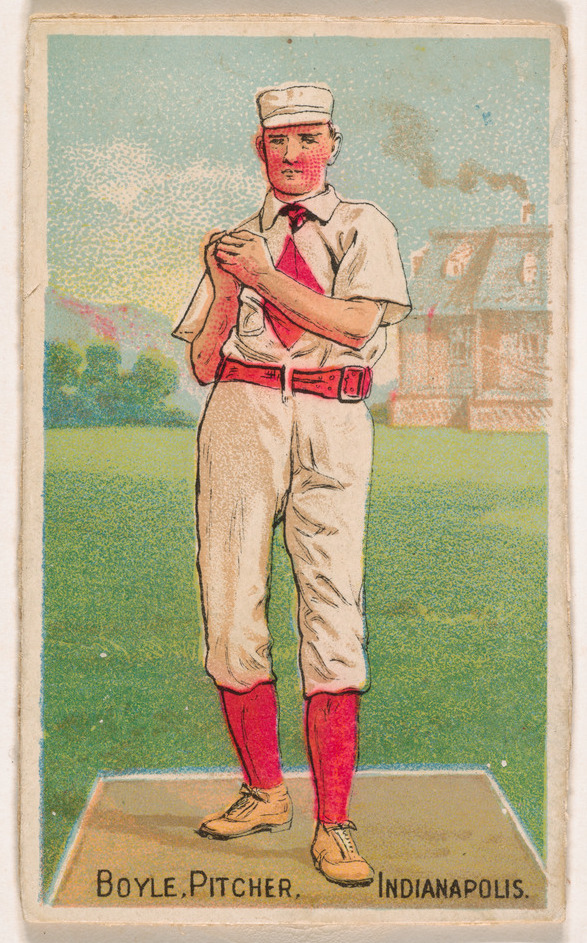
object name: baseball card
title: Boyle, Pitcher, Indianapolis, from the Gold Coin series (N284) for Gold Coin Chewing Tobacco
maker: d. buchner & co., new york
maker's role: publisher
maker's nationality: american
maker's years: 1850-1900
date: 1887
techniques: color lithograph, drawing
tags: men,baseball,athletes